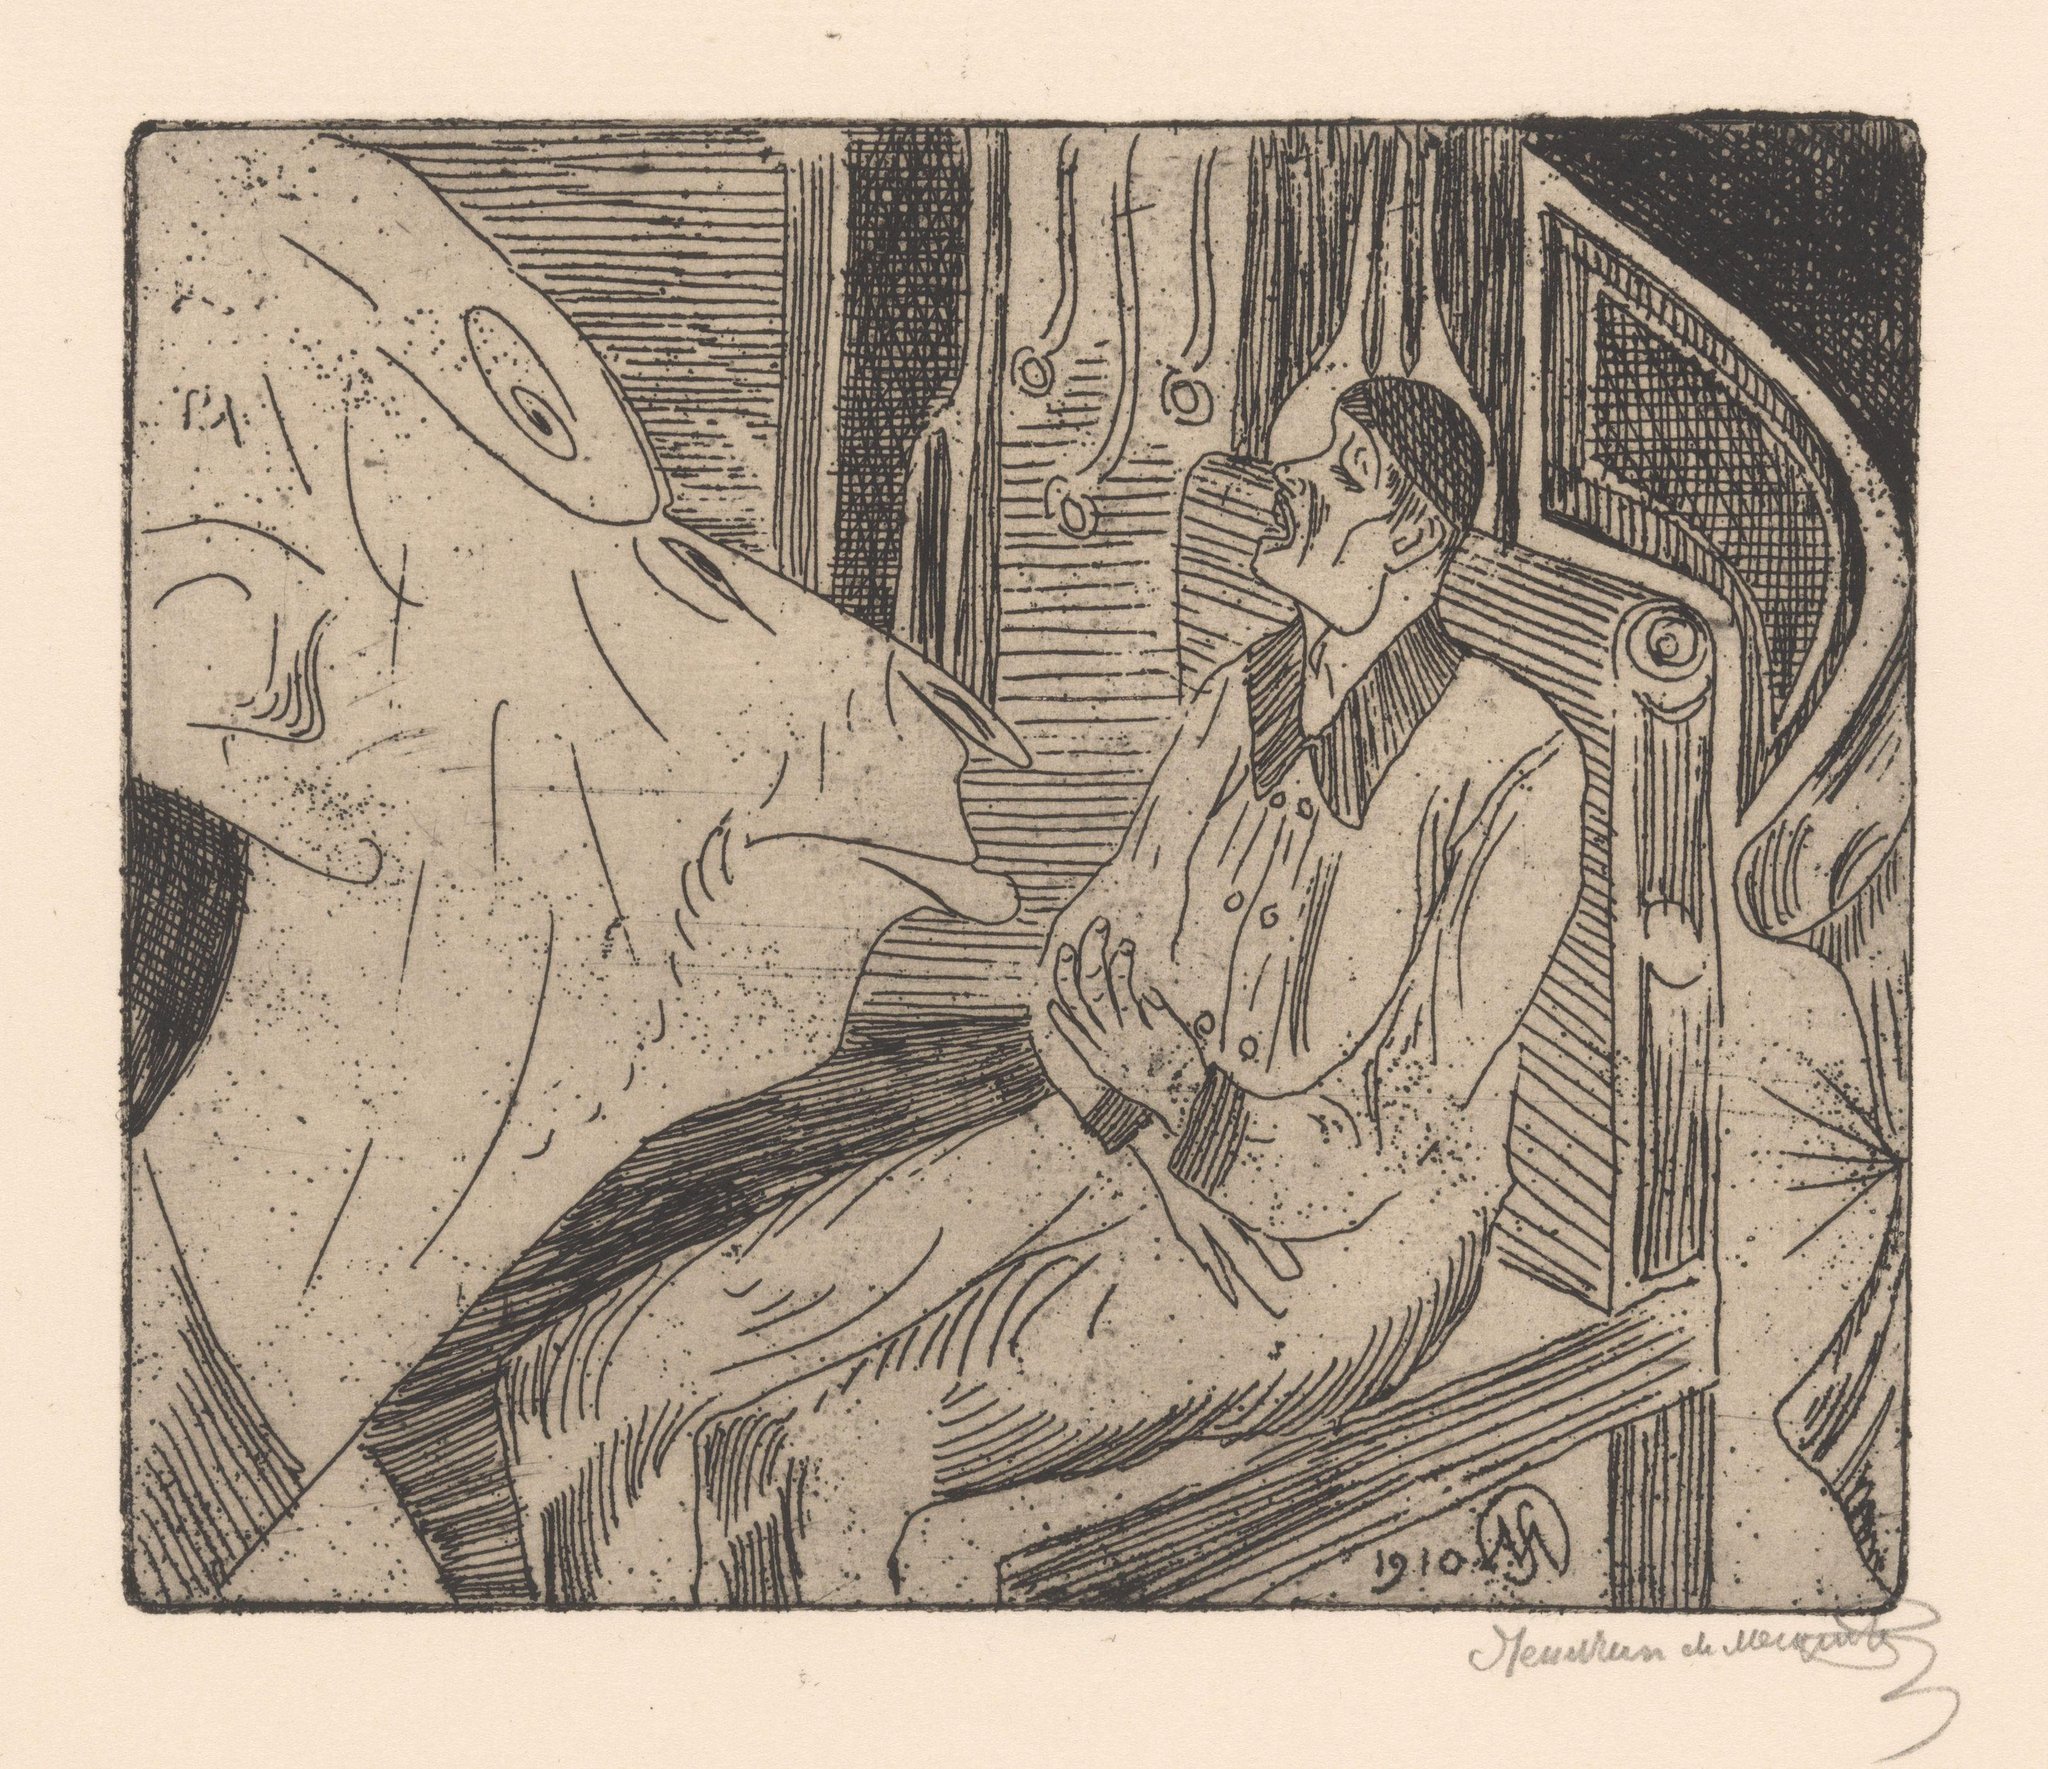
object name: print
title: Groteske verbeeldingen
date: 1910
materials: paper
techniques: etching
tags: sitting figure, caricatures (human types), lips pressed together, head-gear: cap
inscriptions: collector's mark: Lugt 2228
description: De man op de stoel draagt een keppel. Links een figuur met spitse neus en vooruitgestoken onderlip.